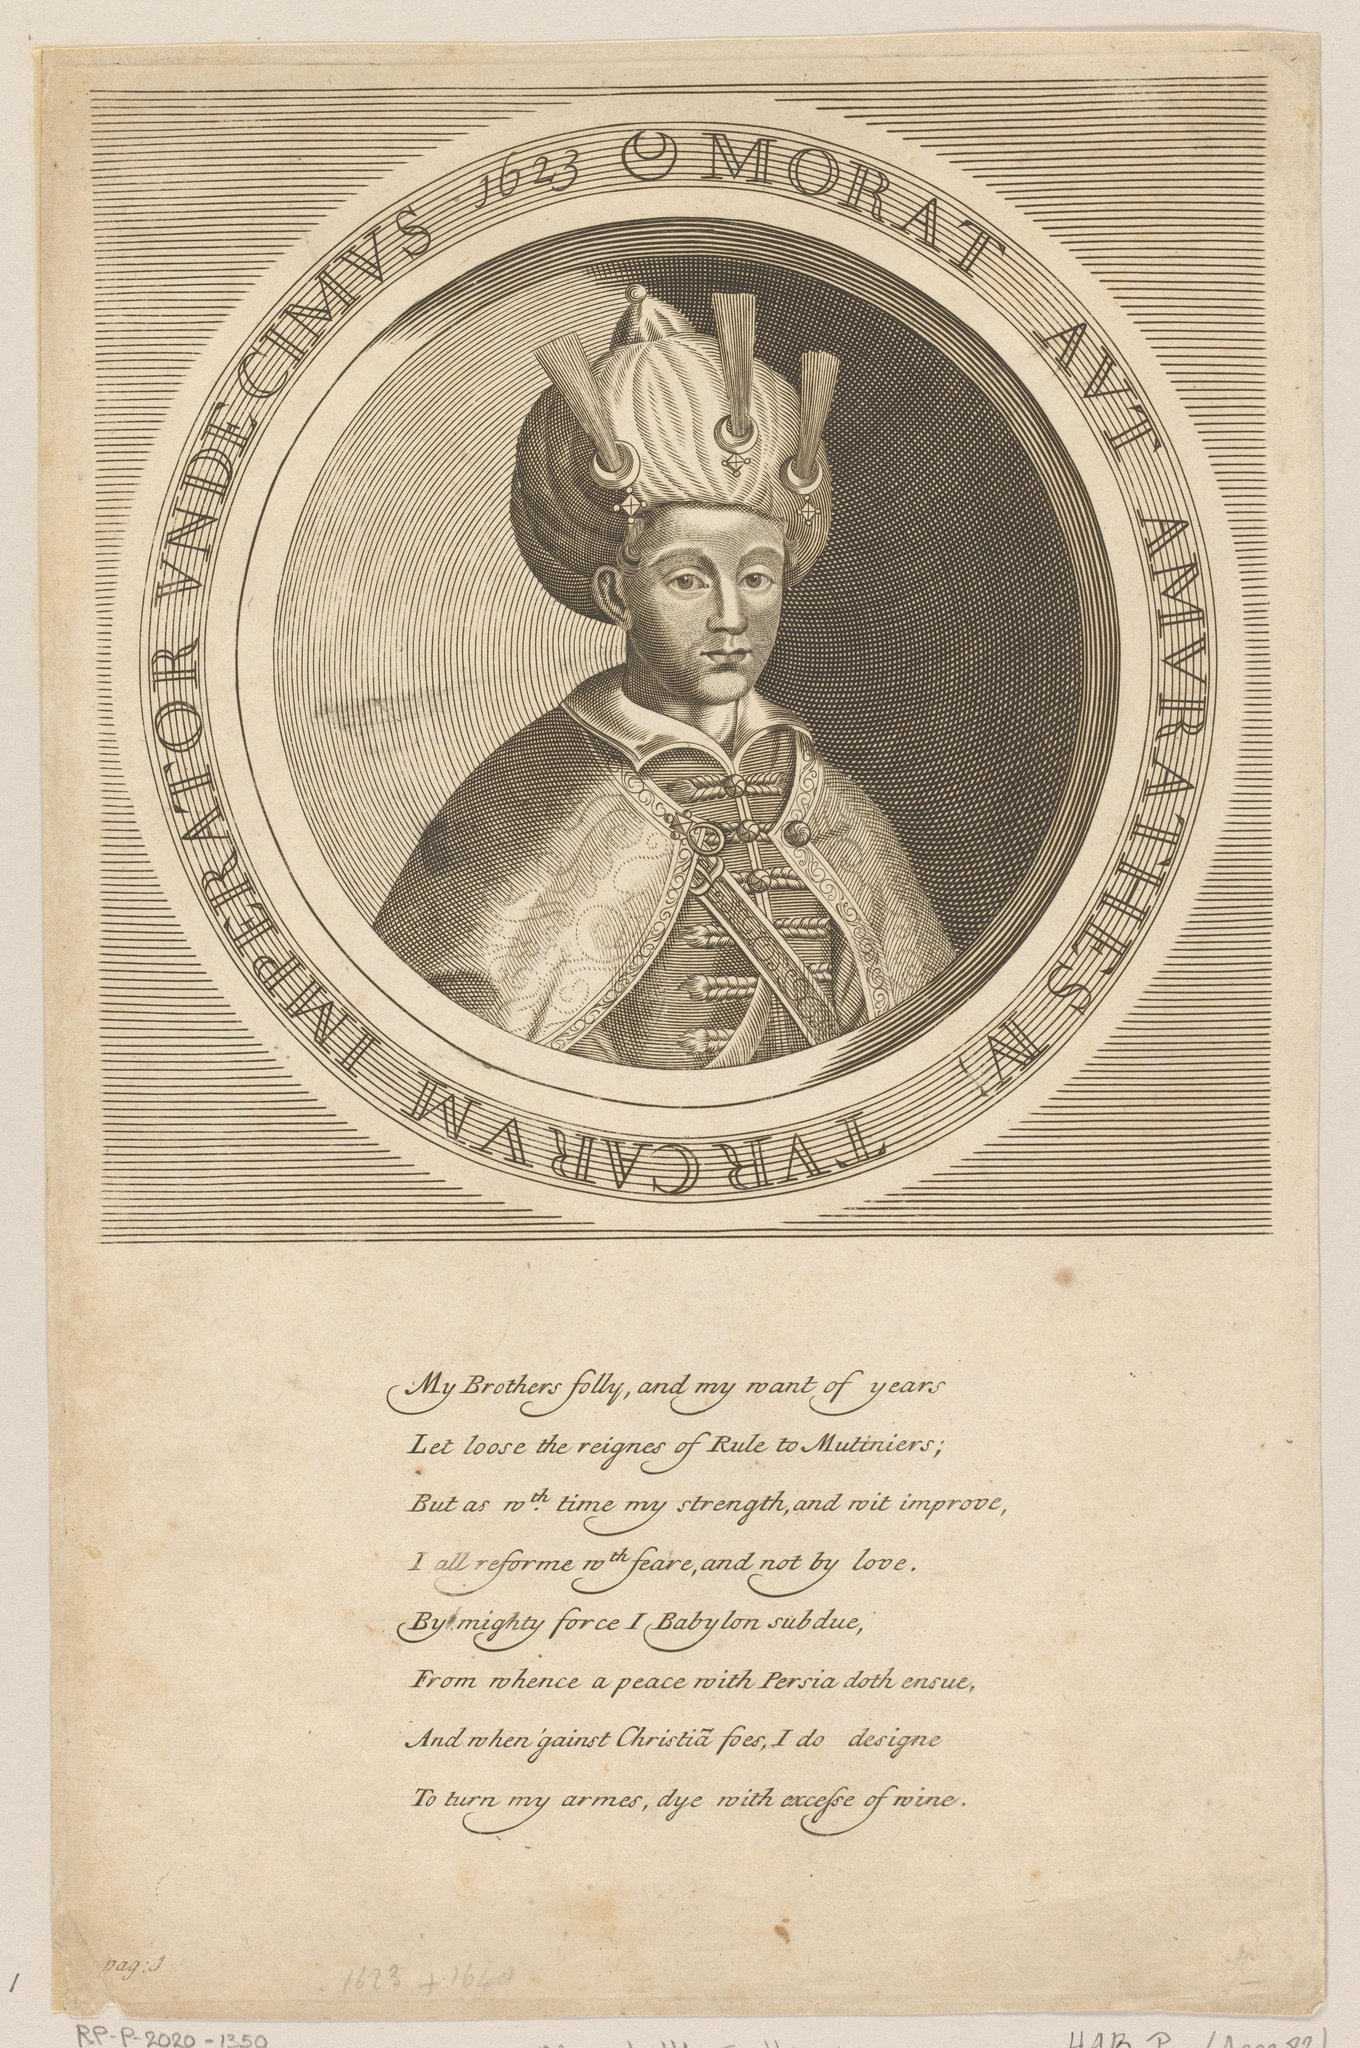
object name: print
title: Portret van Murat IV, sultan van het Ottomaanse Rijk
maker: Anonymous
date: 1623-1699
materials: paper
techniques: engraving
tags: historical persons